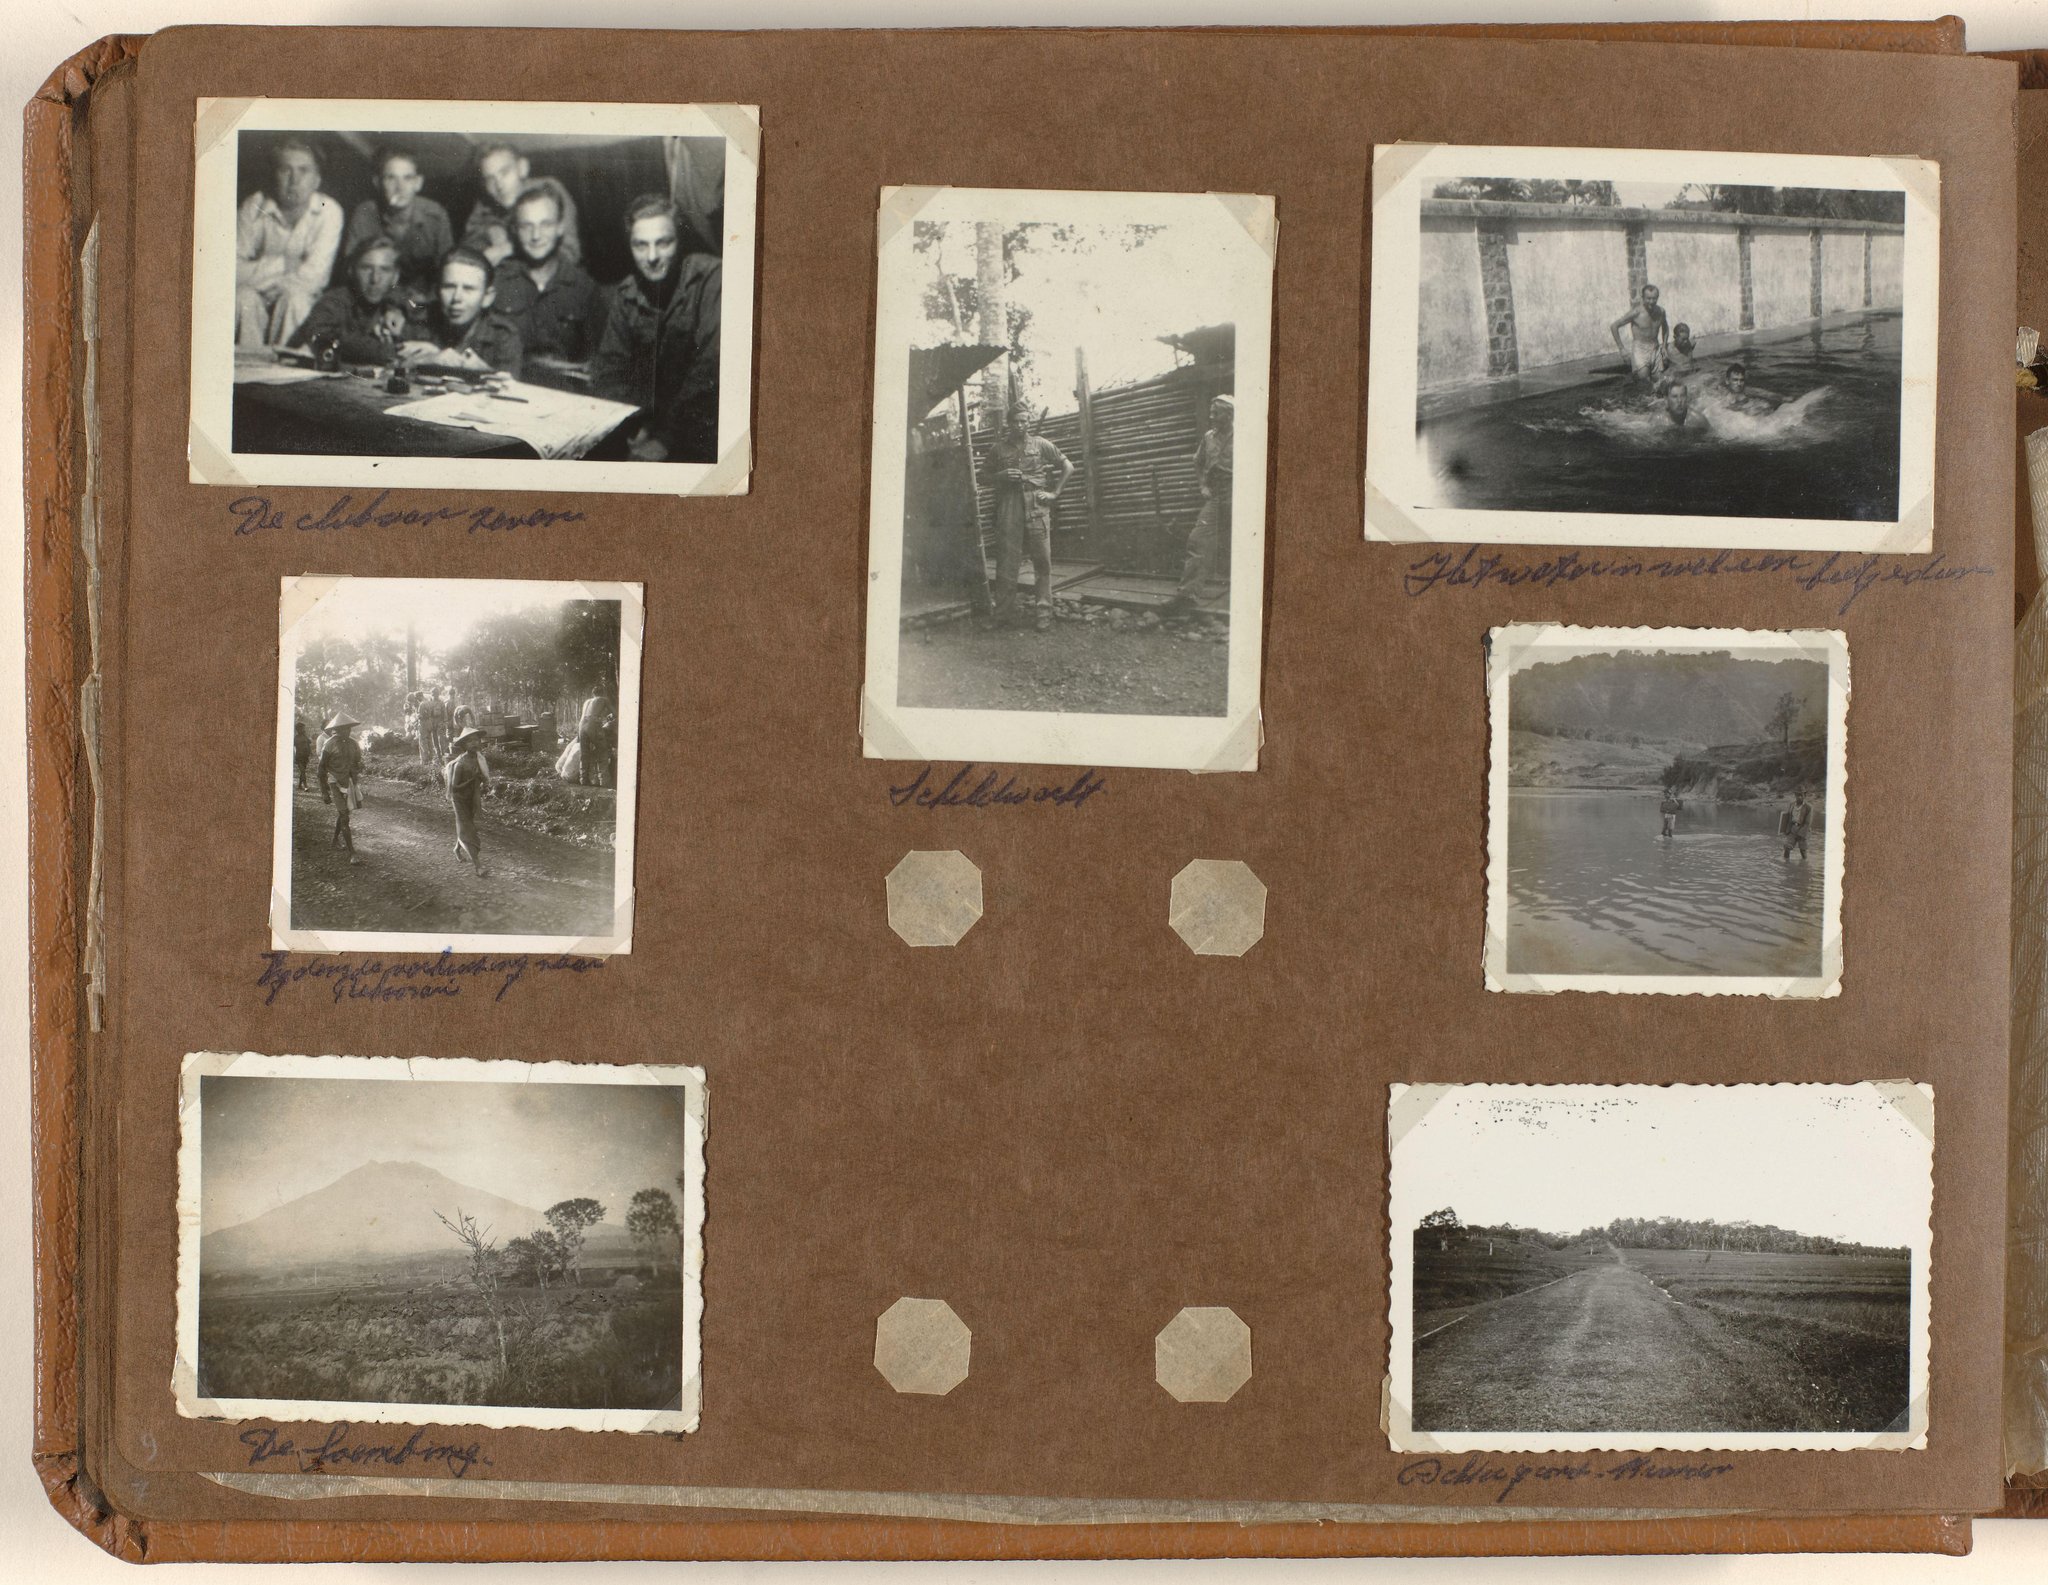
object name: photograph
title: Verblijf en verhuizing tentenkamp Reksosari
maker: Anonymous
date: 1948-1949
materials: paper, photographic support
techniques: photography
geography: reksosari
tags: the company, the unit, the troop ~ military service, (military) camp with tents, landscapes in tropical and sub-tropical regions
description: Albumblad met zeven foto's van verschillende activiteiten rondom het tentenkamp Reksosari. Soldaten slaan het kamp op en vervoeren het naar de volgende plaats, soldaten op hun post en soldaten die een duik nemen in een waterbassin met het onderschrift 'Het water is wel een beetje koud'.